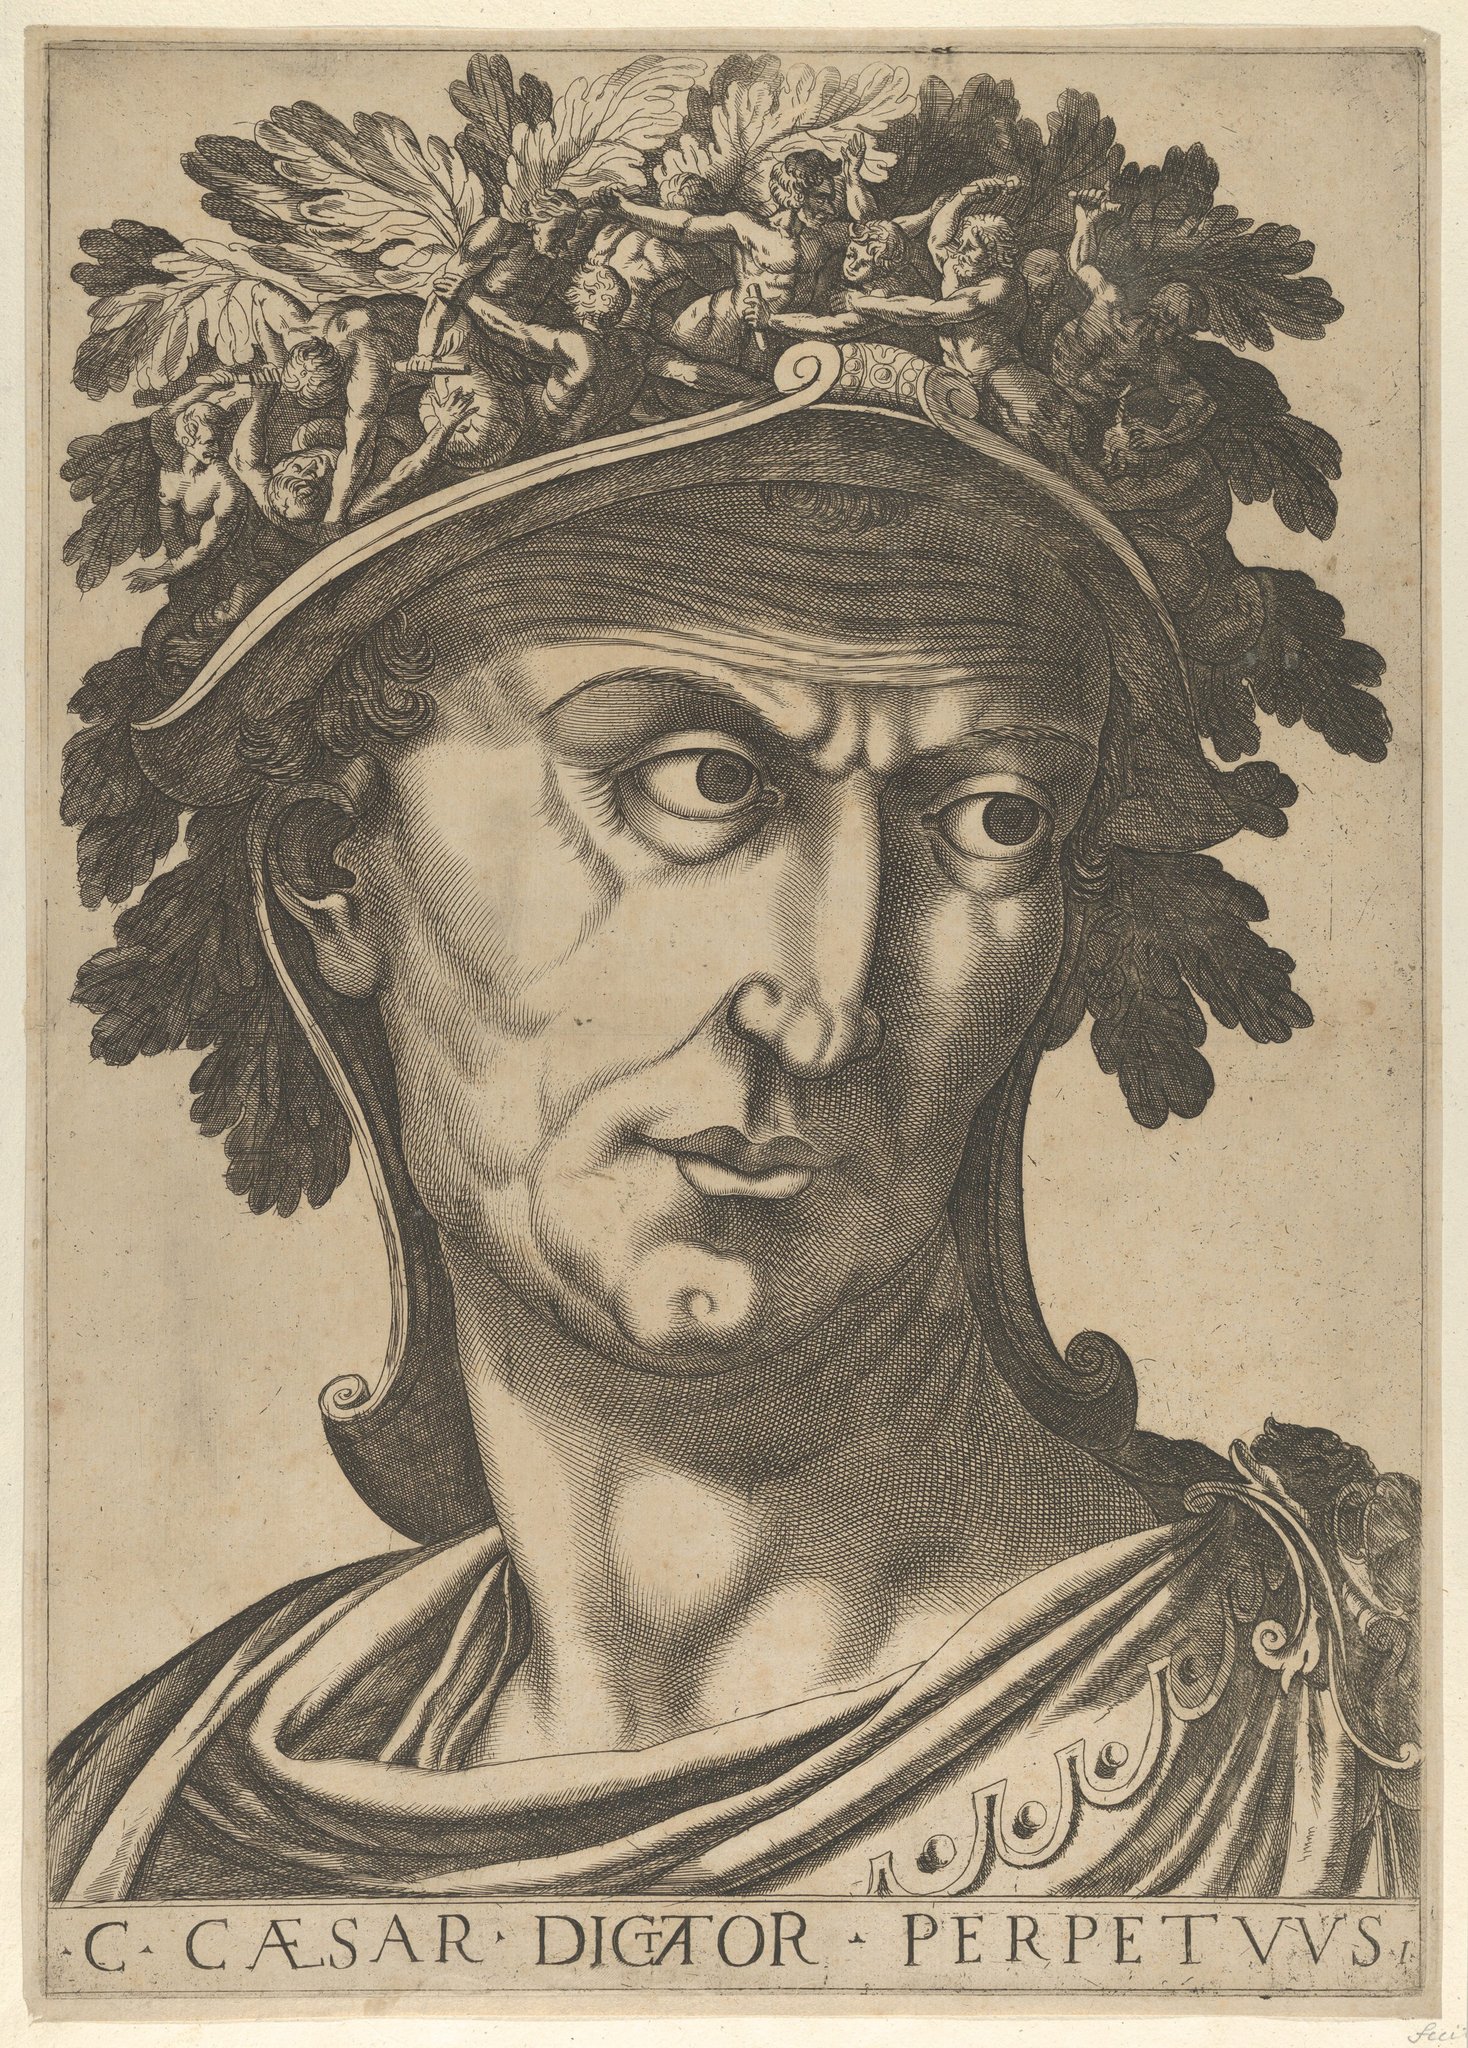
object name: print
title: Plate 1: Julius Caesar looking to the right, from 'The Twelve Caesars'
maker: Anonymous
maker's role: artist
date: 1610-1640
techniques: engraving, etching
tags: julius caesar,portraits